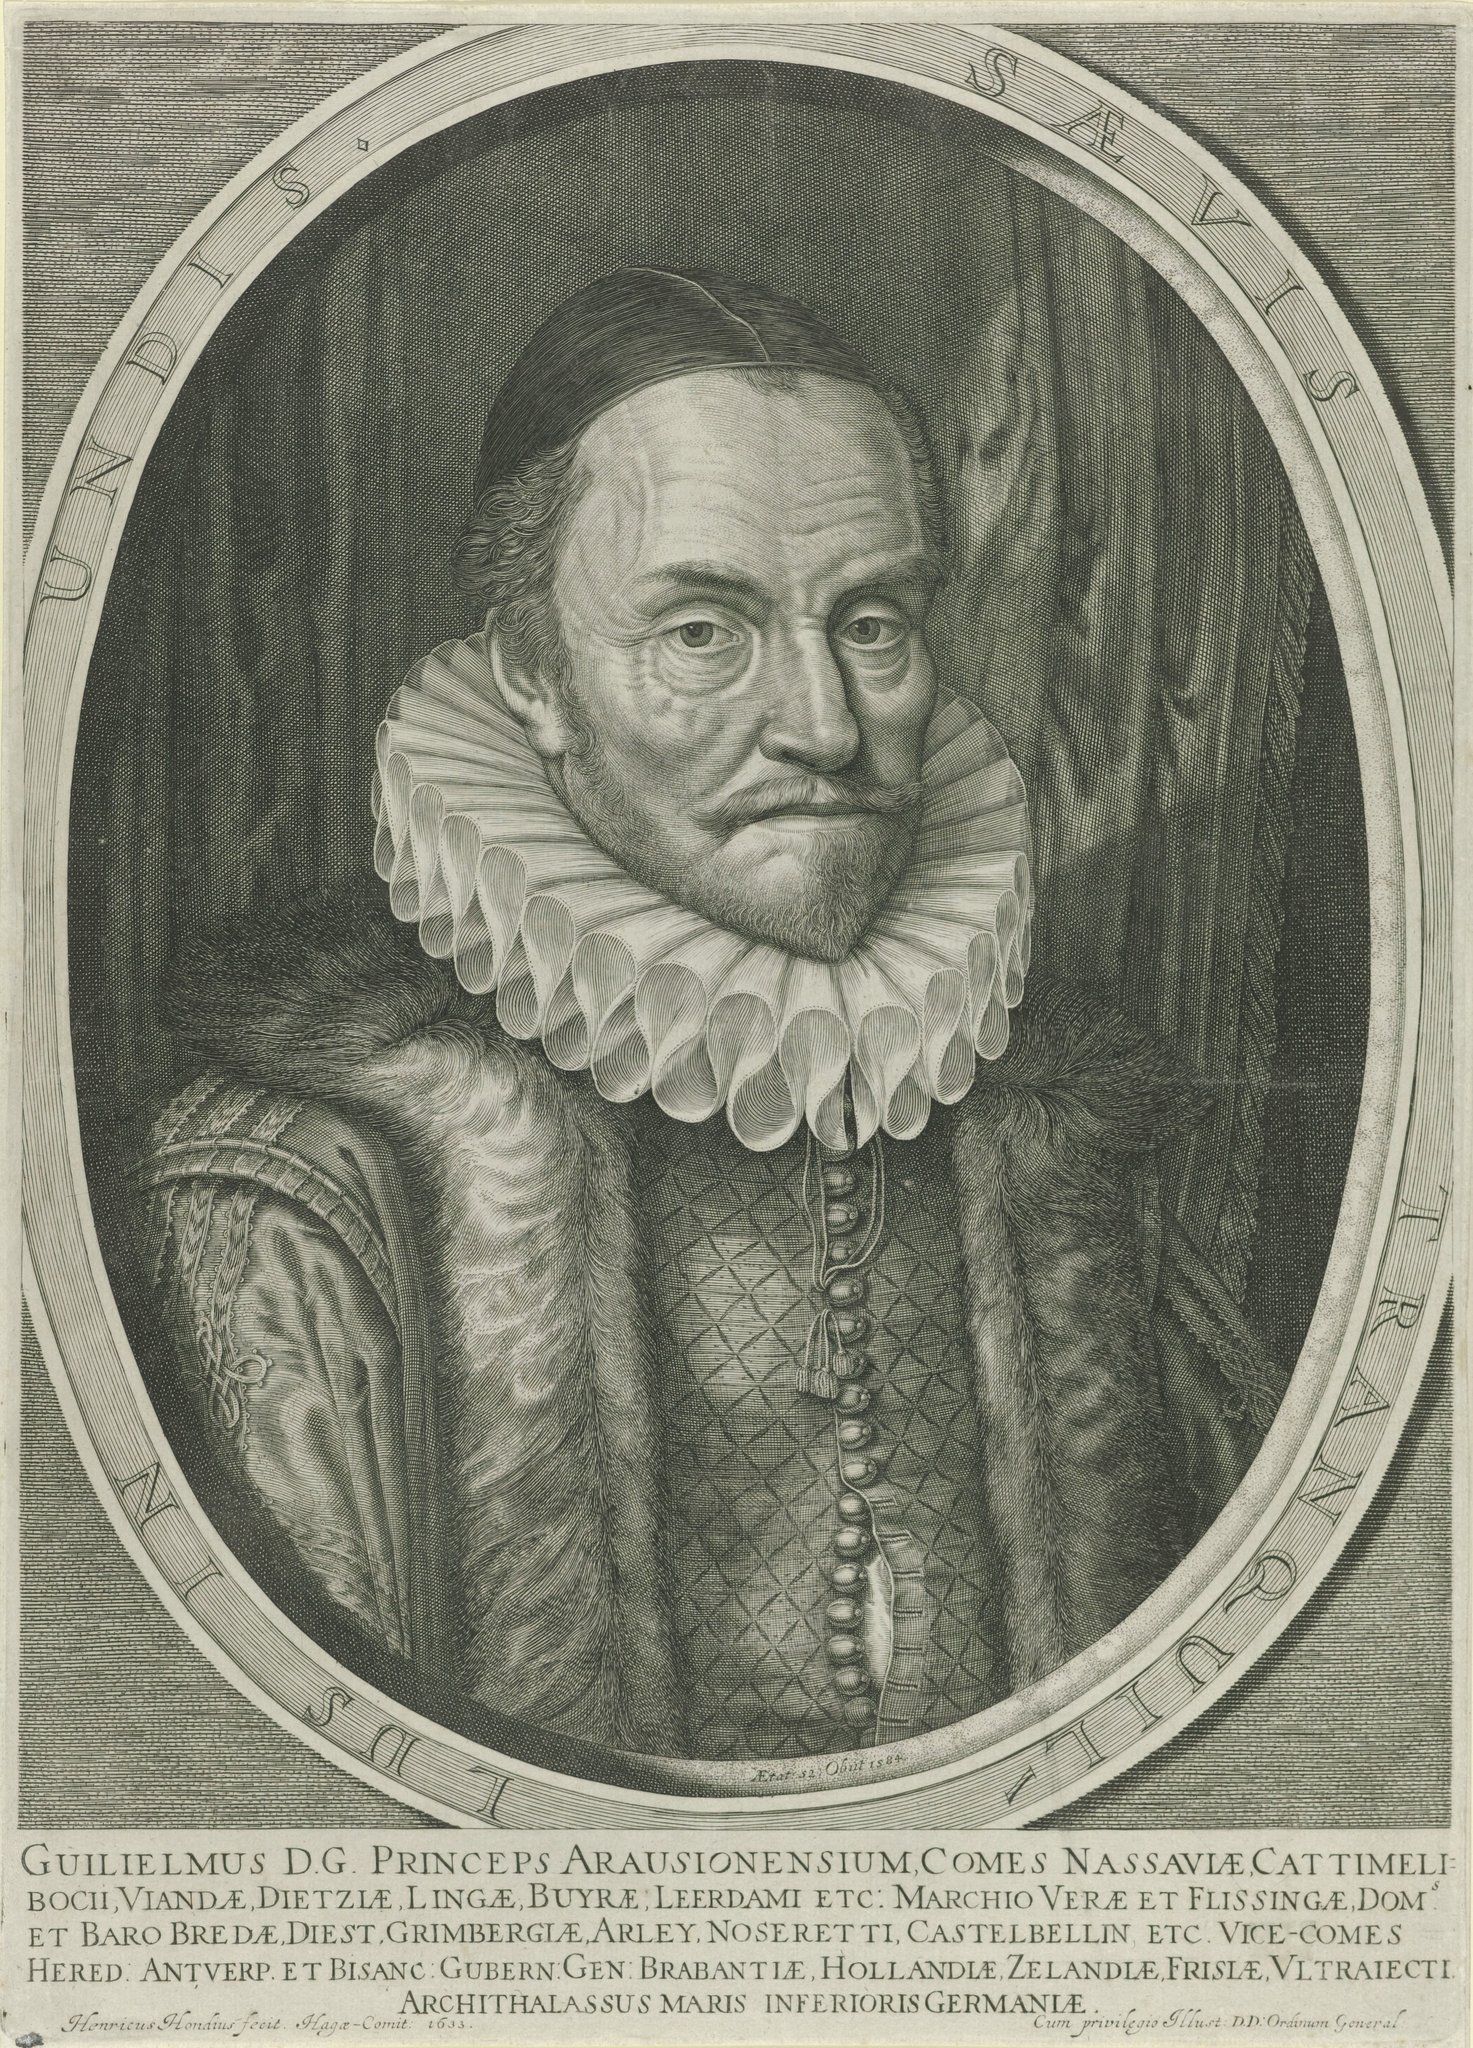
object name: print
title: Portret van Willem I, prins van Oranje, op 52-jarige leeftijd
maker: hendrick hondius (i)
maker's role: draughtsman, print maker, publisher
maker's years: 1573-1650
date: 1633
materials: paper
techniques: engraving, etching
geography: the hague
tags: william i (prince of orange)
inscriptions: collector's mark: Lugt 963, collector's mark: Lugt 2165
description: De hier vermelde titel verwijst naar de hoogst verkregen titel van de geportretteerde, niet per se naar de titel die de geportretteerde op deze voorstelling draagt.